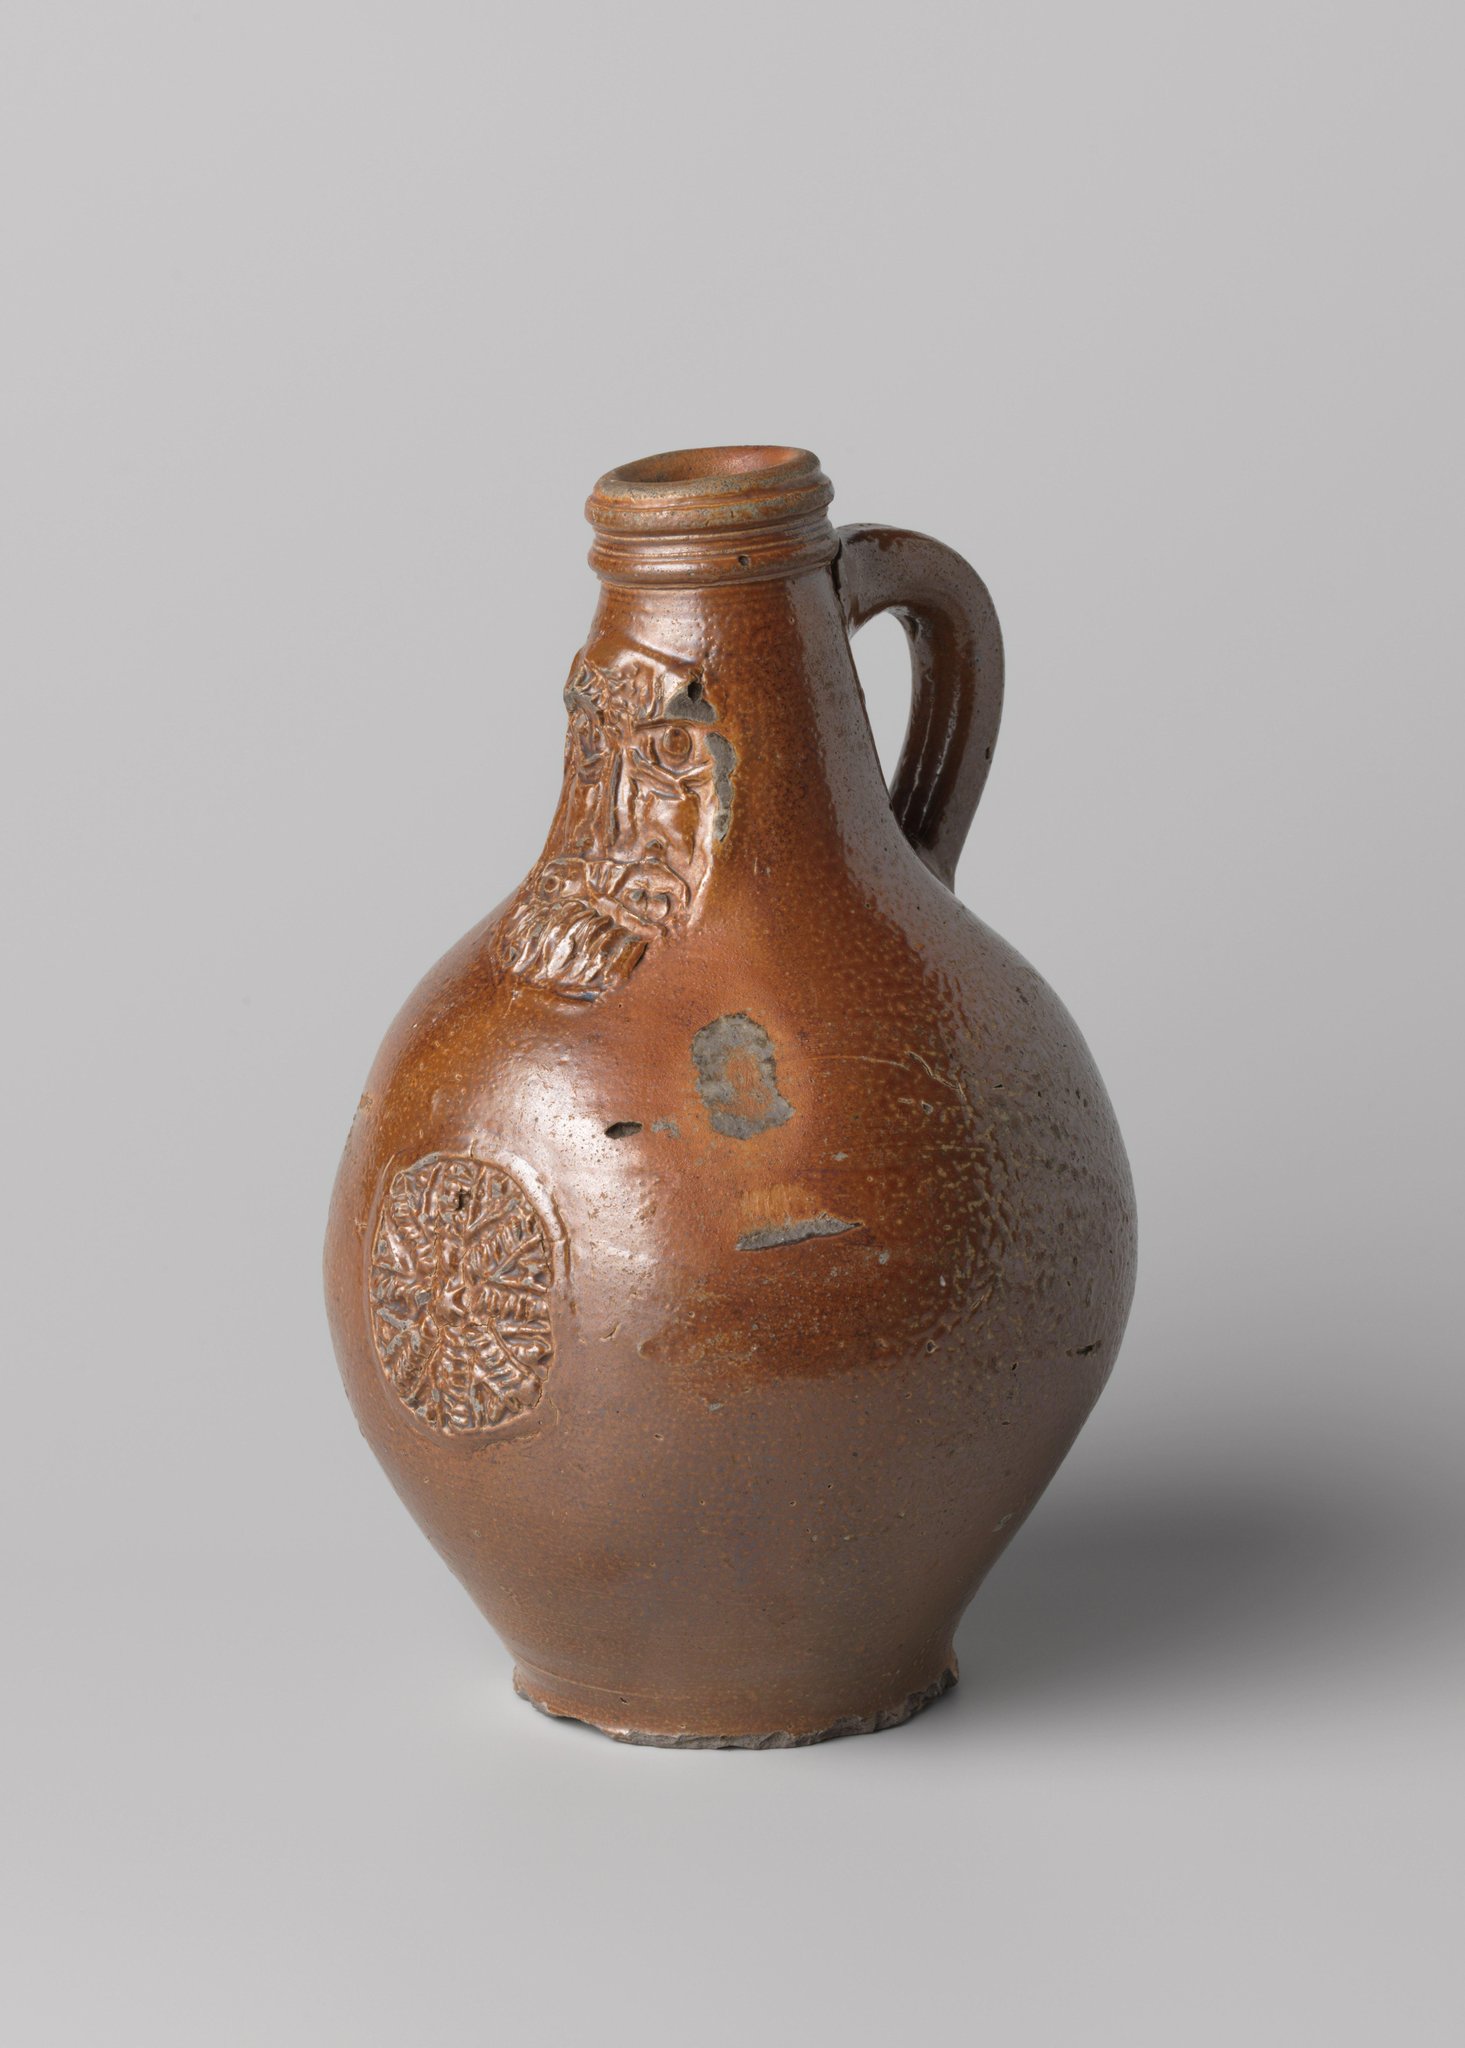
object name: jug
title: Jug (Bartmann jug) with a roundel in a medallion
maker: Anonymous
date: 1650-1749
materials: engobe, glaze, stoneware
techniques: firing, forming, relief, turning, vitrification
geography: frechen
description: Kruik (baardmankruik) van steengoed op standvlak met een bolvormige buik en smalle nek. Het C-vormige oor is bevestigd aan de nek en de schouder. Profielen op de nek. Bedekt met een bruine engobe. In reliëf op de buik een gedrukt en opgelegd medaillon met een rozet. Op de nek, doorlopend op de schouder, een baardman. Frechen.